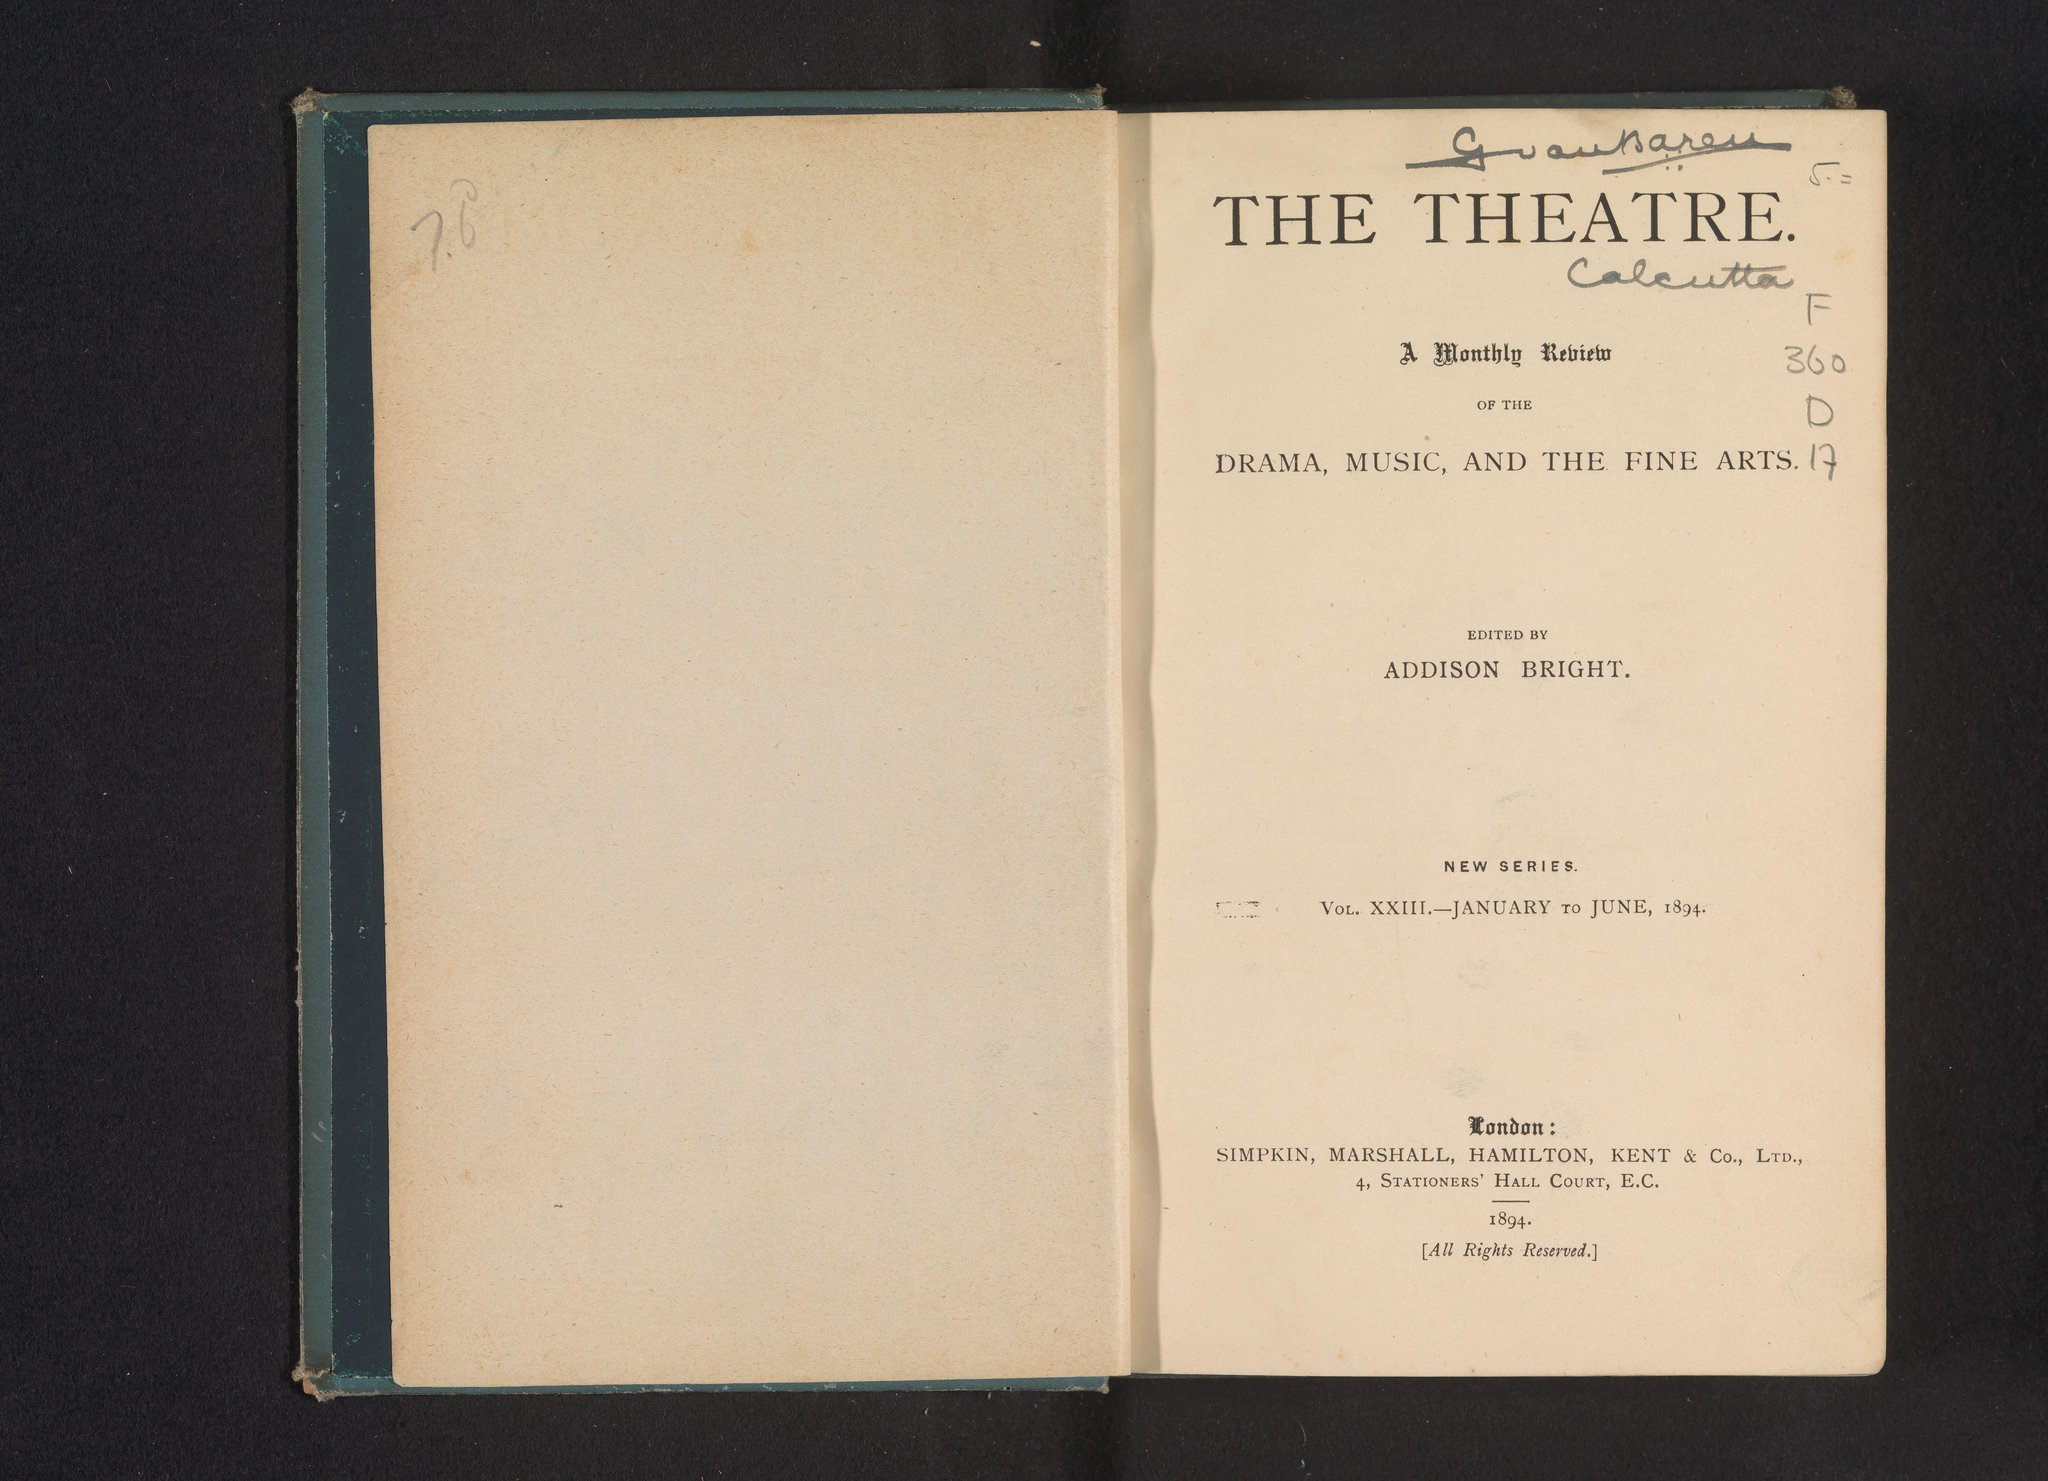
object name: magazine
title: The theatre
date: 1894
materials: cardboard, paper, textile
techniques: carbon print, printing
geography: london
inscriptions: annotation: ‘[...]/ Calcutta’